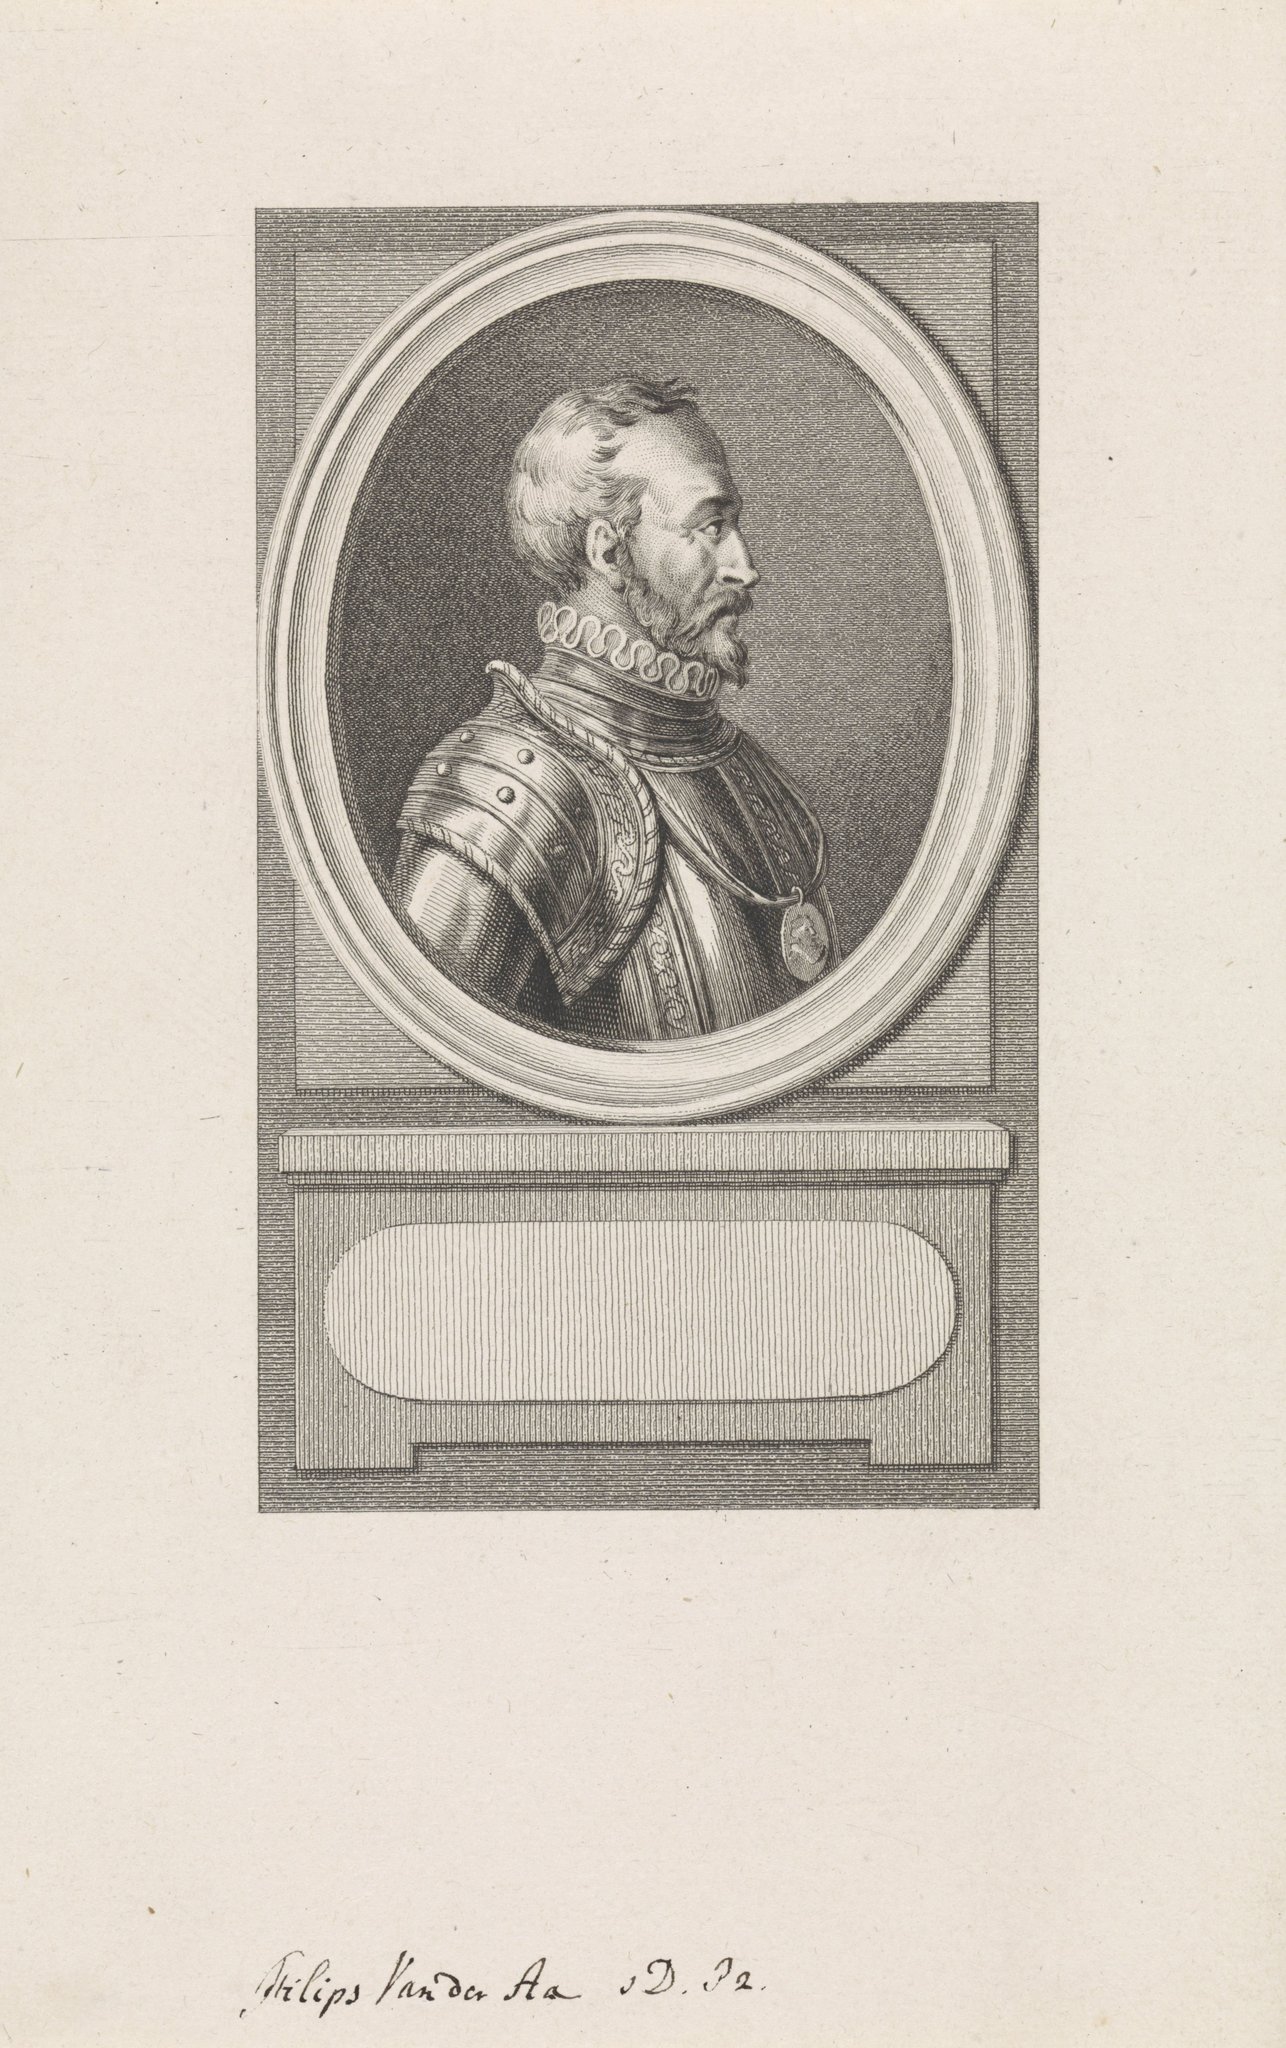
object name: print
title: Portret van Filips van der Aa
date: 1785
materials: paper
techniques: engraving, etching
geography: amsterdam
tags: bevelhebber, staatsman, filips van der aa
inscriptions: inscription: ‘Filips van der Aa 1D. P. 2.’, collector's mark: Lugt 240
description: Latere staat prent gebruikt als boekillustratie in: Kok, Jacobus. Vaderlandsch woordenboek : met kaarten, plaaten en pourtraitten. Amsterdam: Johannes Allart, 1785-1796. Deel I.